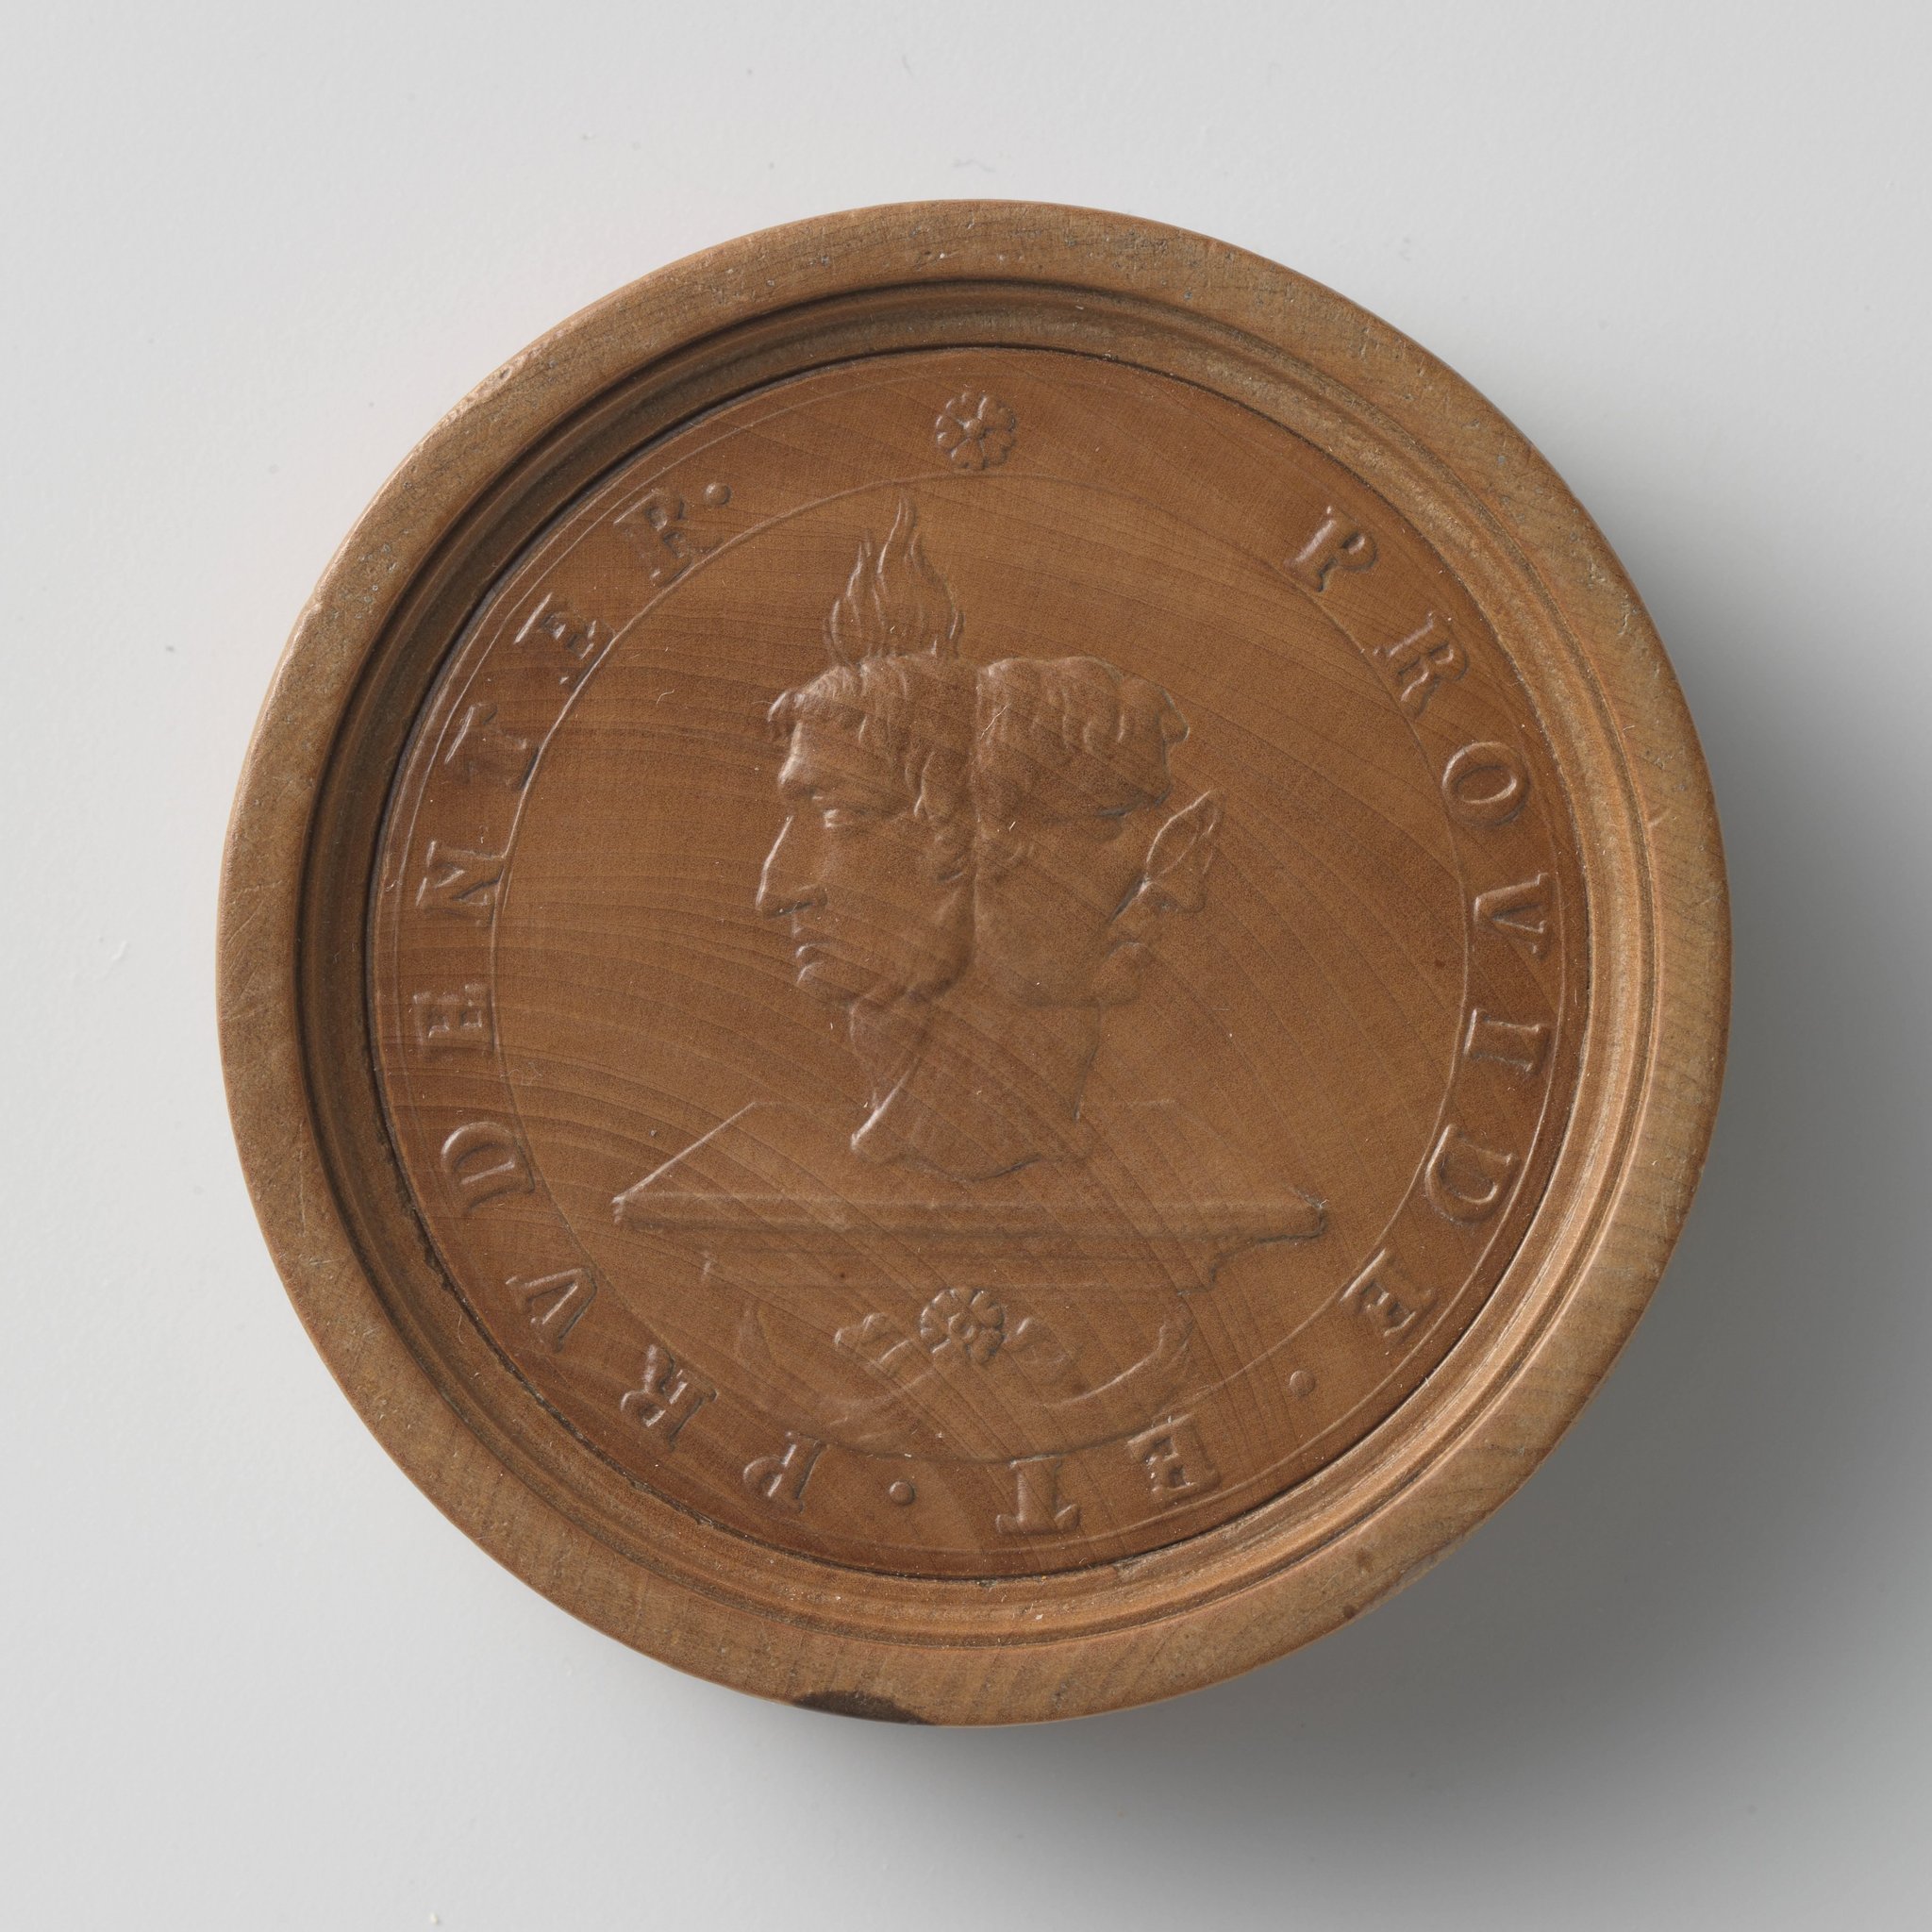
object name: sculpture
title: Damschijf met voorstelling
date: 1675-1700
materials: wood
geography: germany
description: Opschrift 'SIC.COECVS.OBERRAT. ', afbeelding van een buste op een sokkel met twee hoofden. Op het één hoofd een vlam en het andere hoofd is de neus dichtgenepen door een knijper. Op d achterkant 'PROVIDE.ET.PRUDENTER'., afbeeldinge van een geblinddoekte putti.